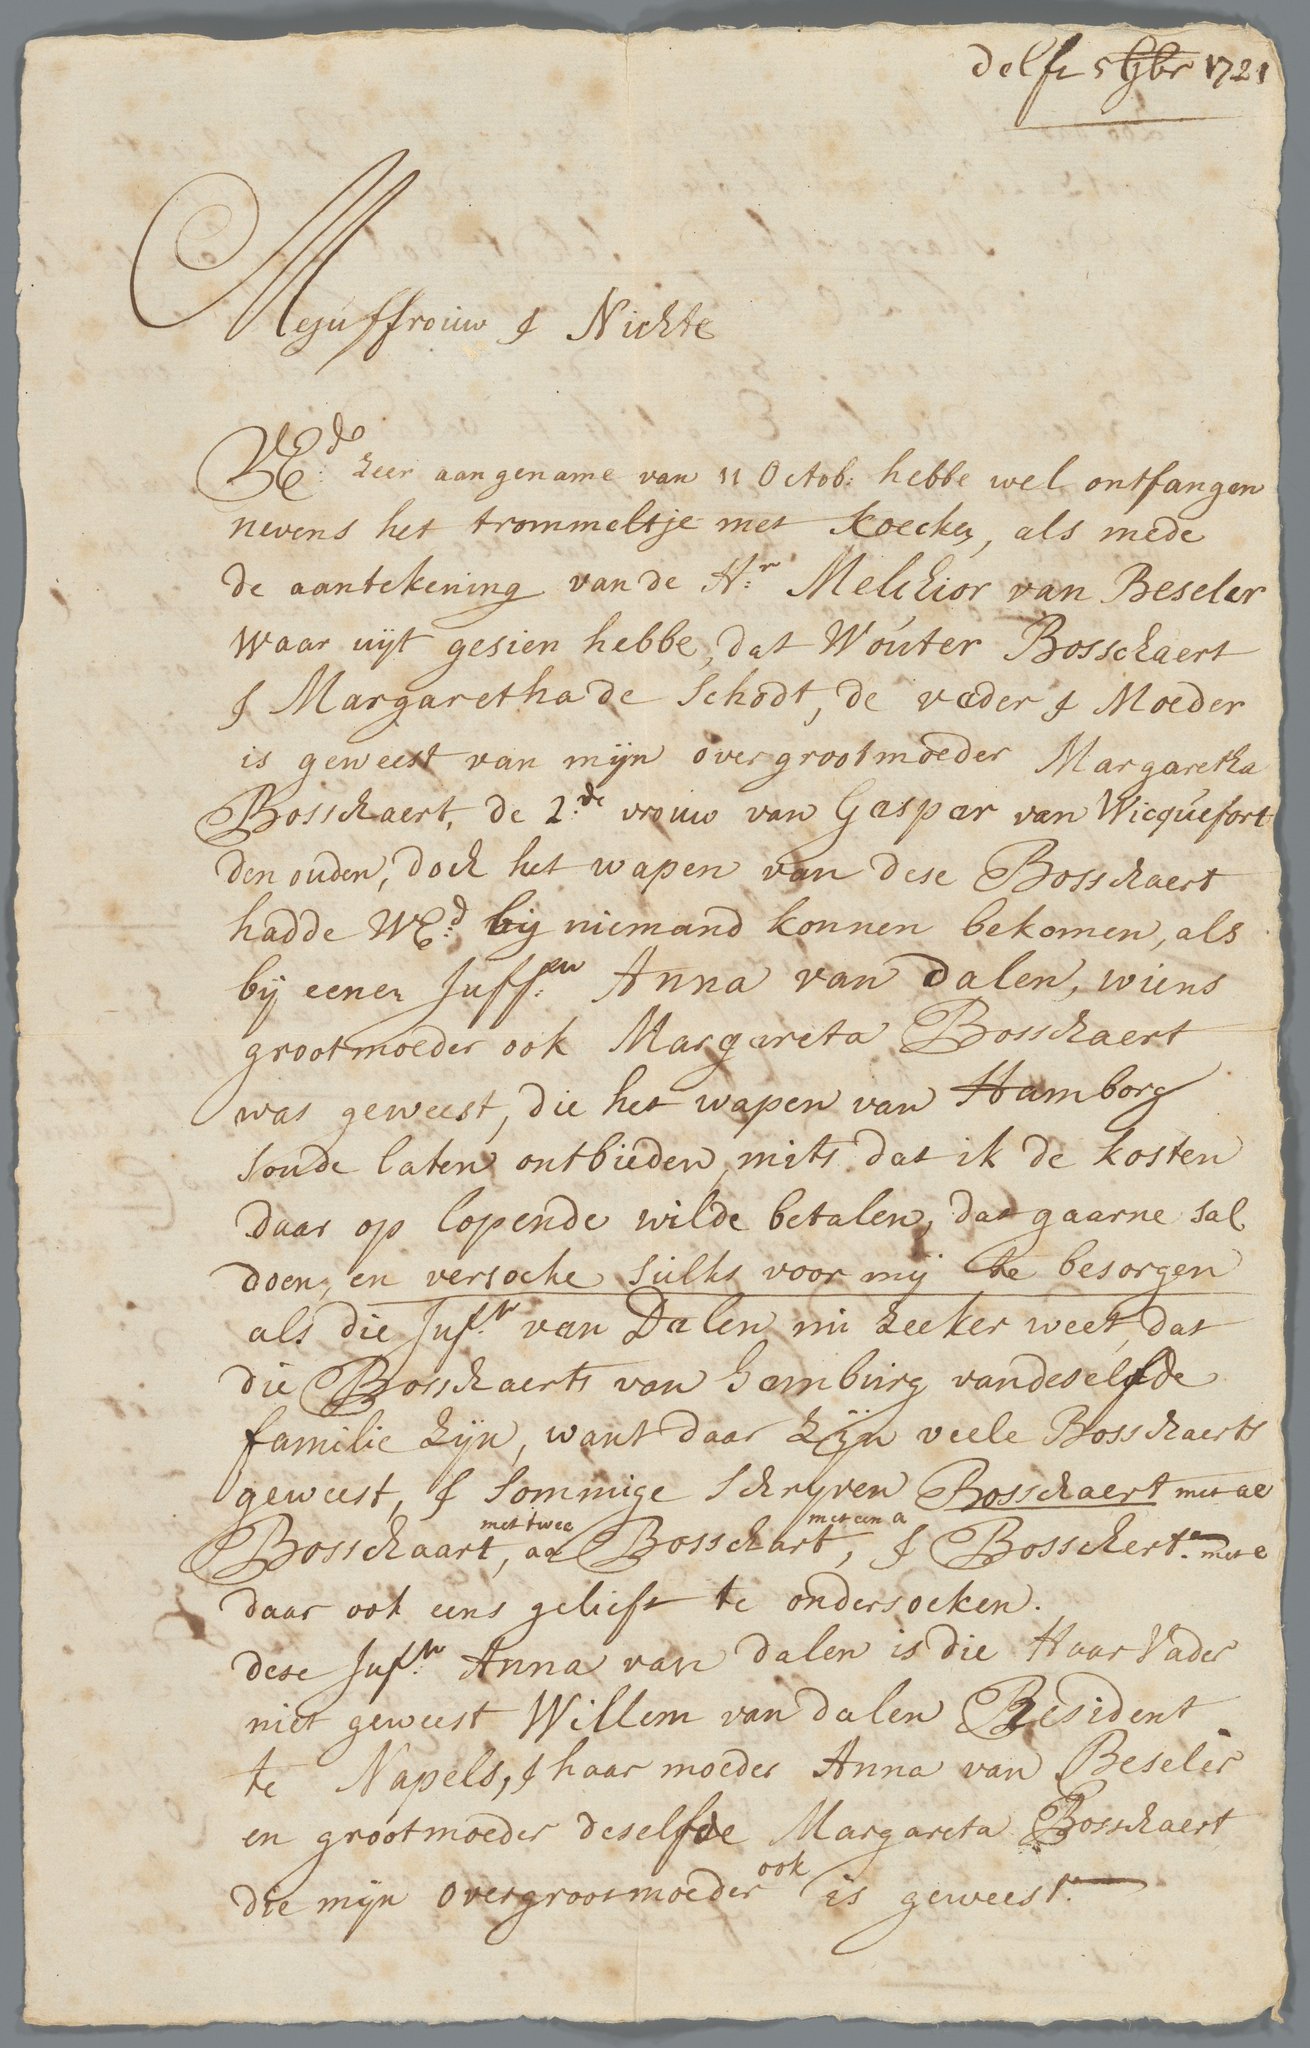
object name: letter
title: Diverse correspondentie met betrekking tot genealogie van het geslacht Rendorp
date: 1700-1799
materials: paper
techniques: writing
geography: netherlands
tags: rendorp, familie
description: Een groep van zes brieven met betrekking tot genealogie van het geslacht Rendorp, behorende bij de brieventas van Joachim Rendorp. De brieven zijn geschreven in 1721, 1732, 1732, 1743 en zonder datum 18e eeuw en zonder datum 19e eeuw.